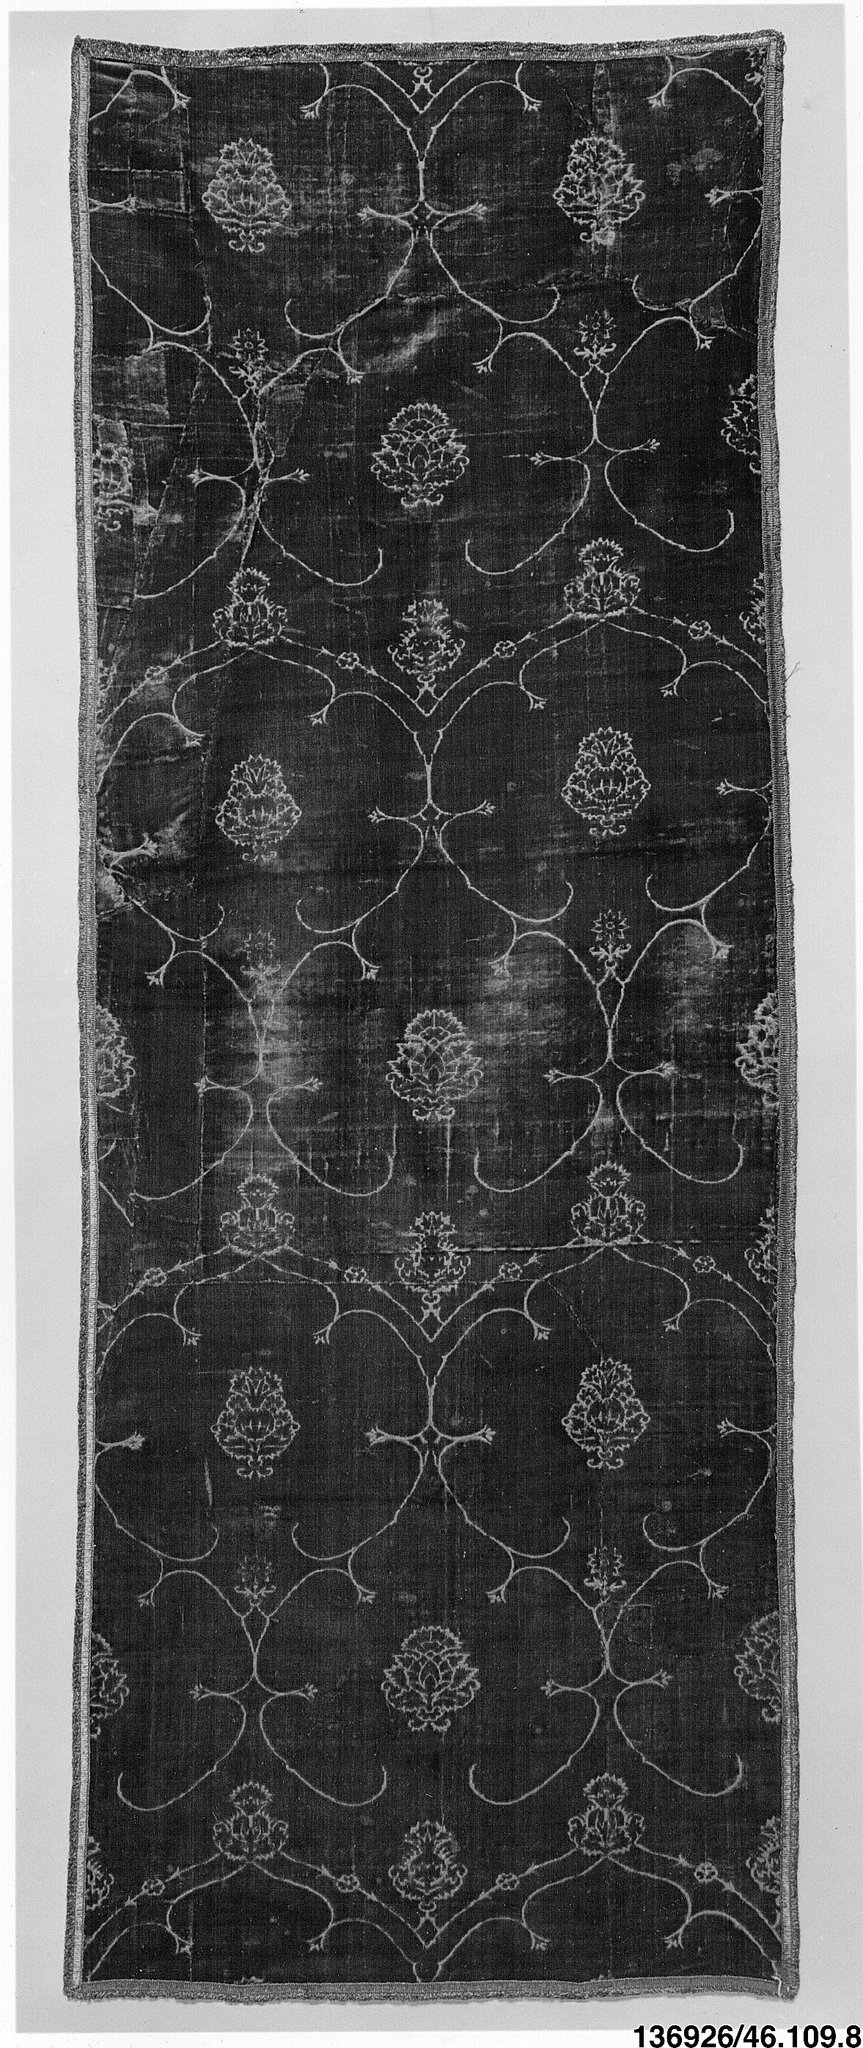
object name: piece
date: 1401-1500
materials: silk